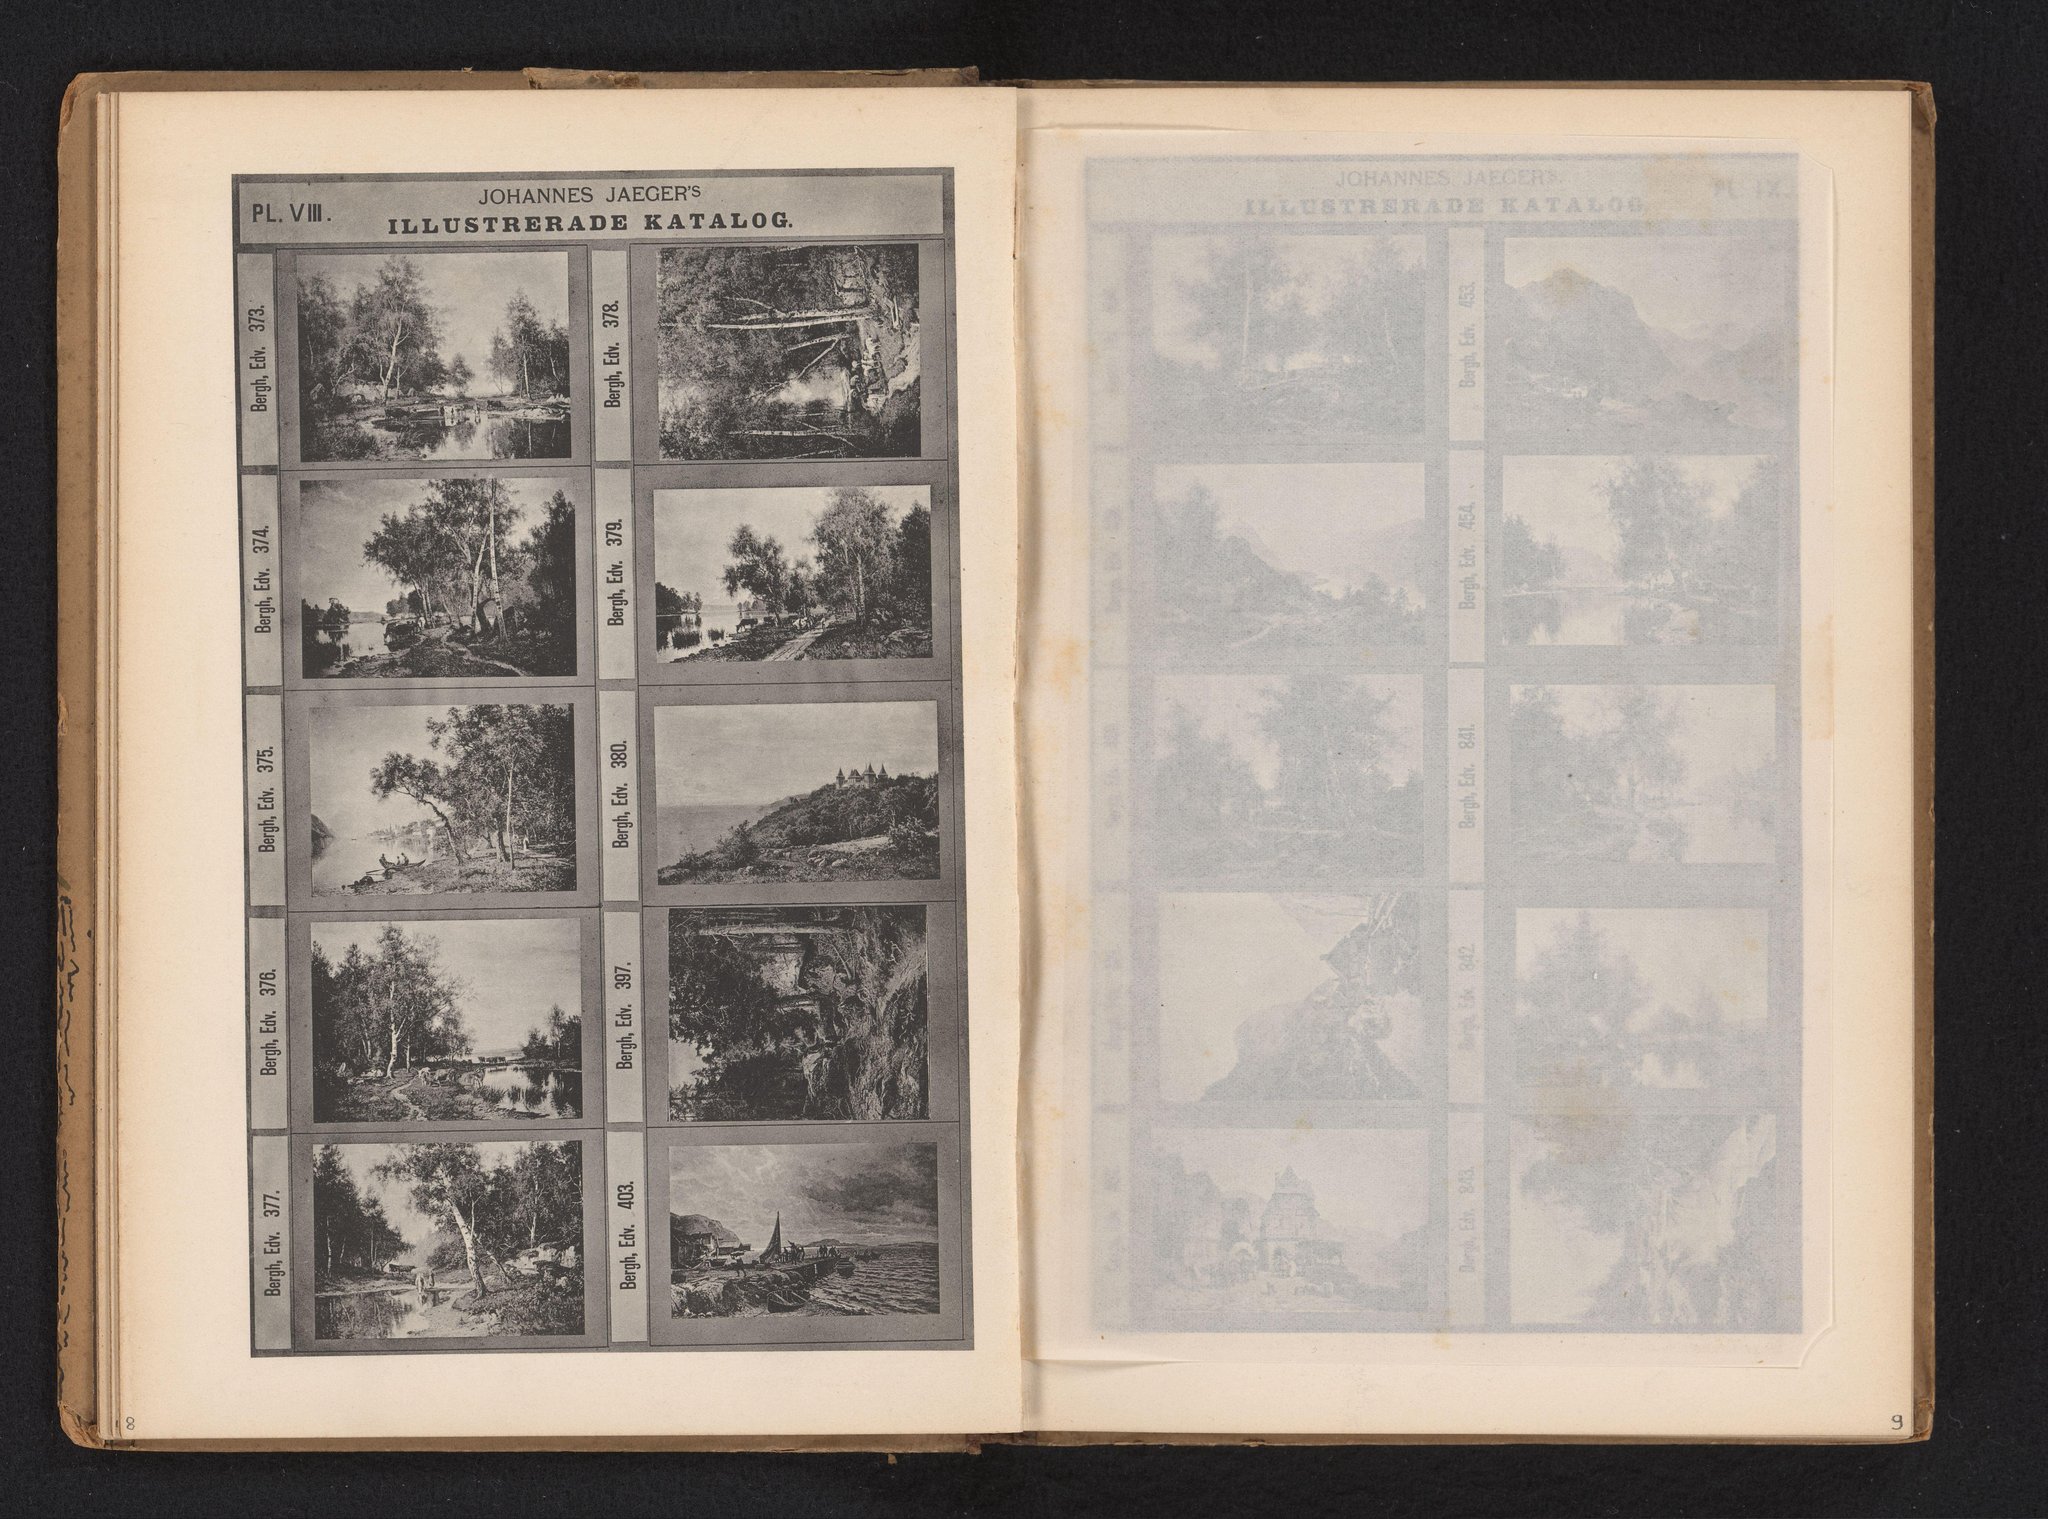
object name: reproduction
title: Johannes Jaeger's Illustrerade Katalog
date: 1872-1882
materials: paper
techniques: photograph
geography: stockholm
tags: landscapes, picture, painting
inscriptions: number: ‘PL. VIII.’